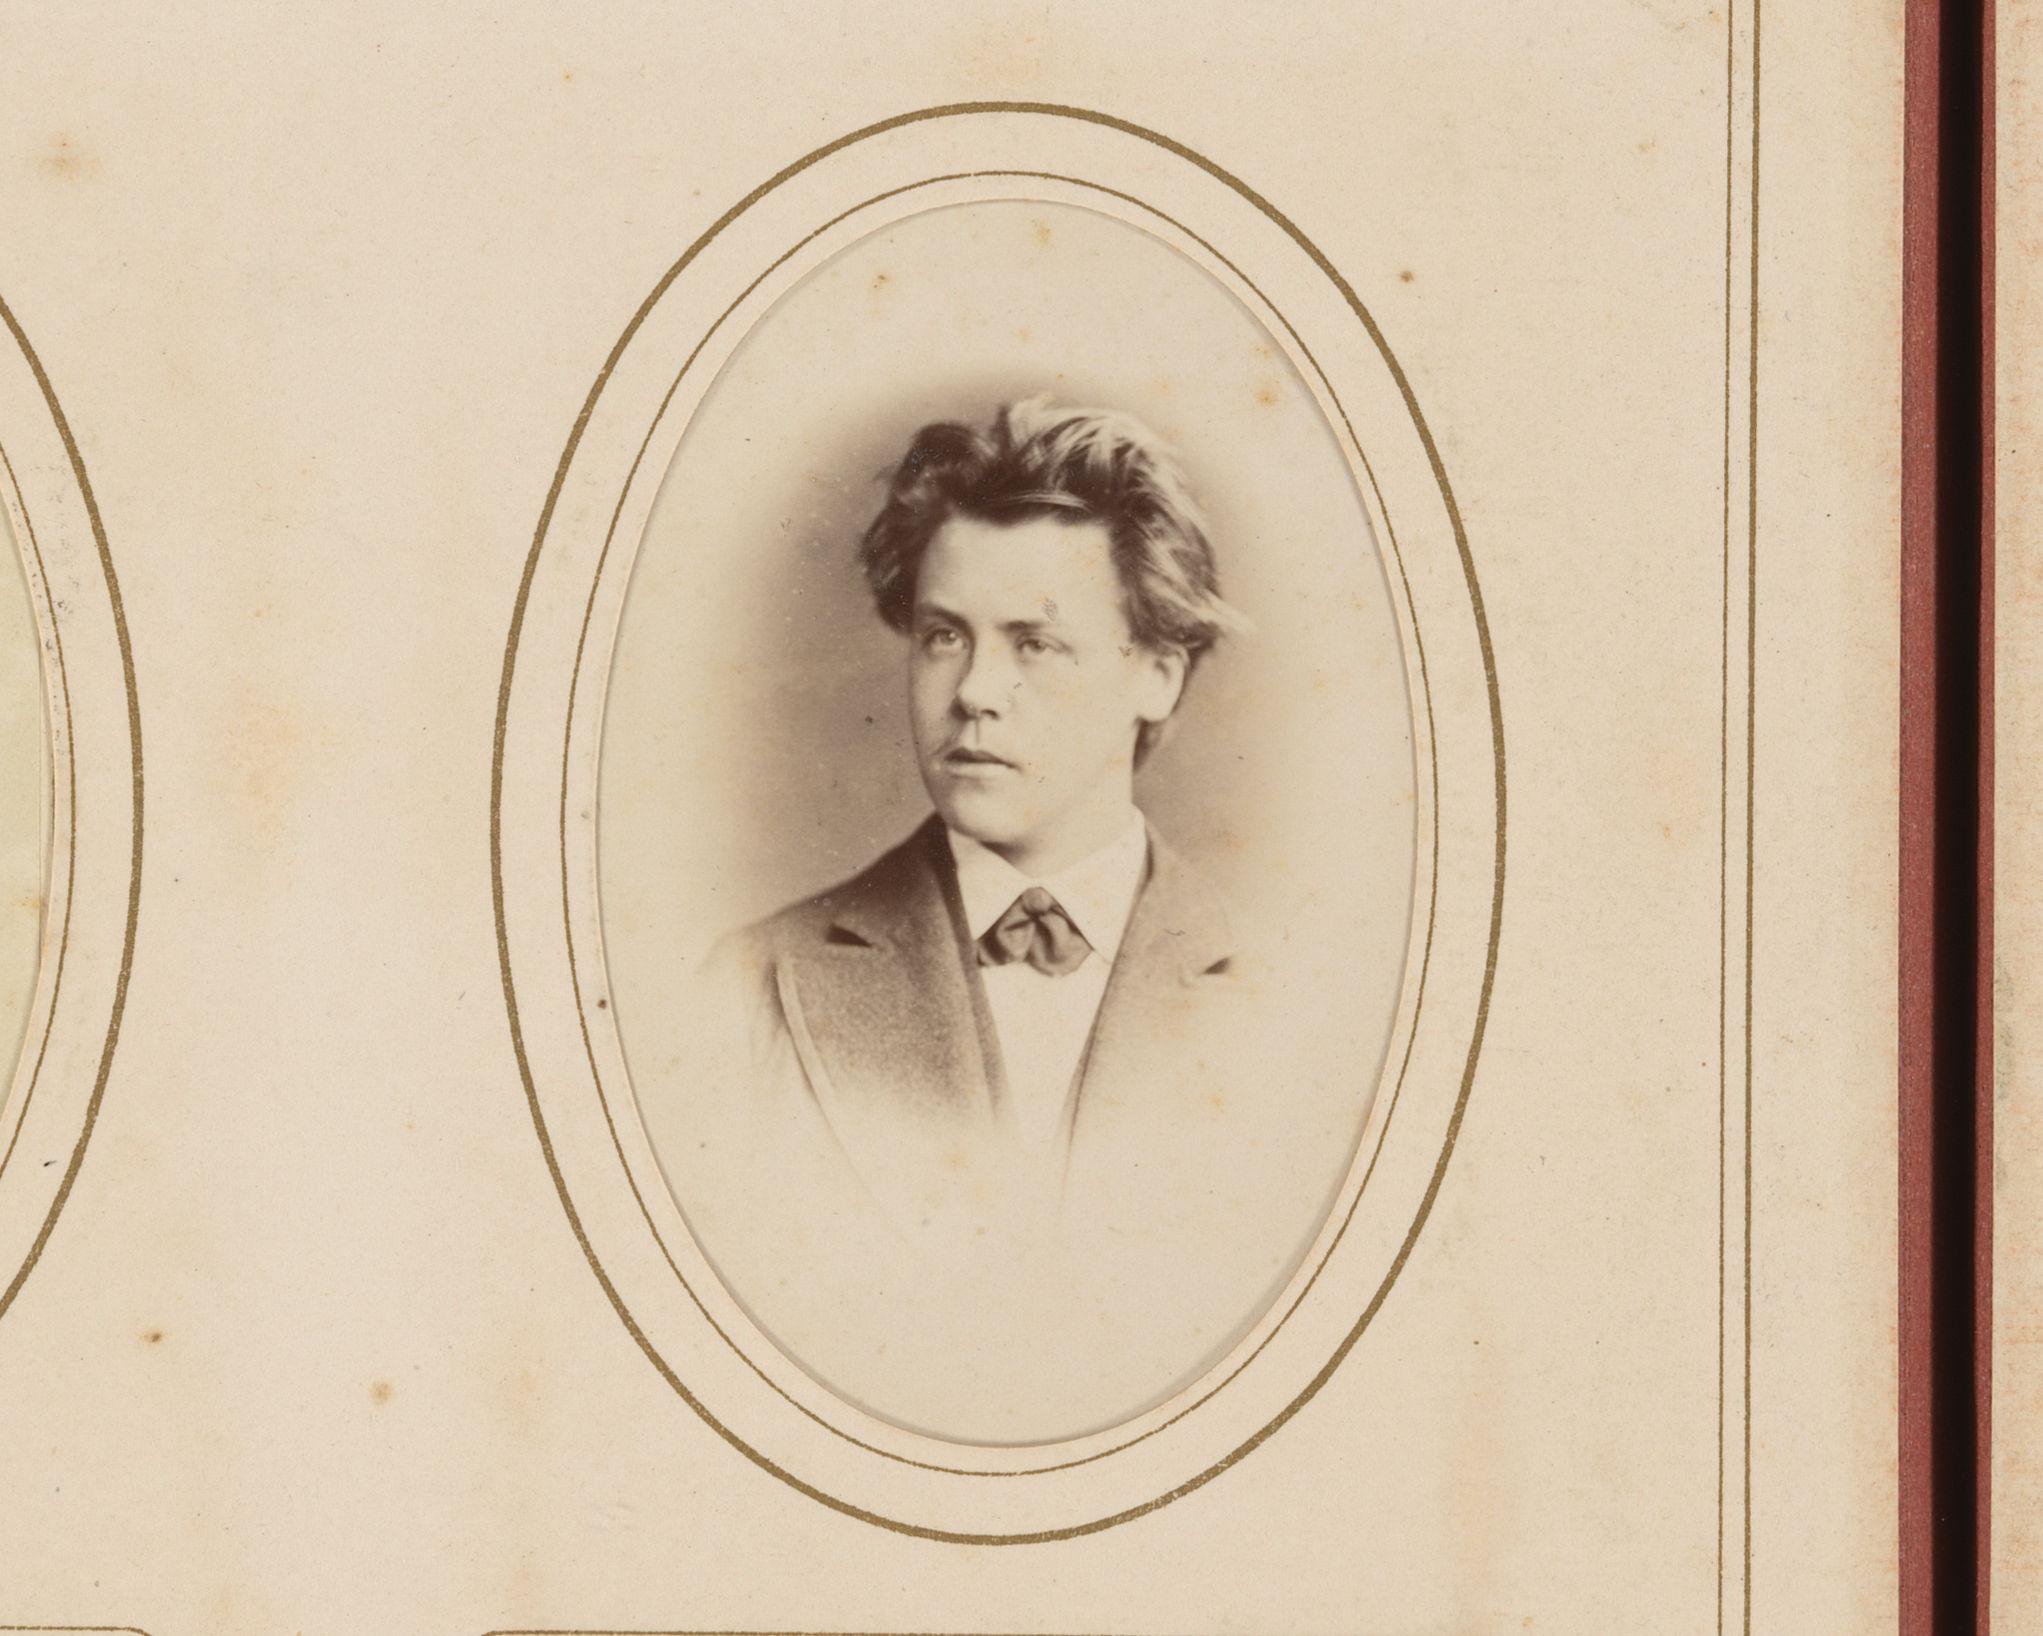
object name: carte de visite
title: Portret van een jongen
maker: albert greiner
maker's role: fotograaf, fotostudio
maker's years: 1833-1890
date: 1861-1874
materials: cardboard, photographic support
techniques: albumen print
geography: amsterdam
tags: boy (child between toddler and youth), historical persons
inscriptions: inscription: ‘A. Greiner/ Photograf/ NIEUWENDIJK L. 87/ AMSTERDAM’